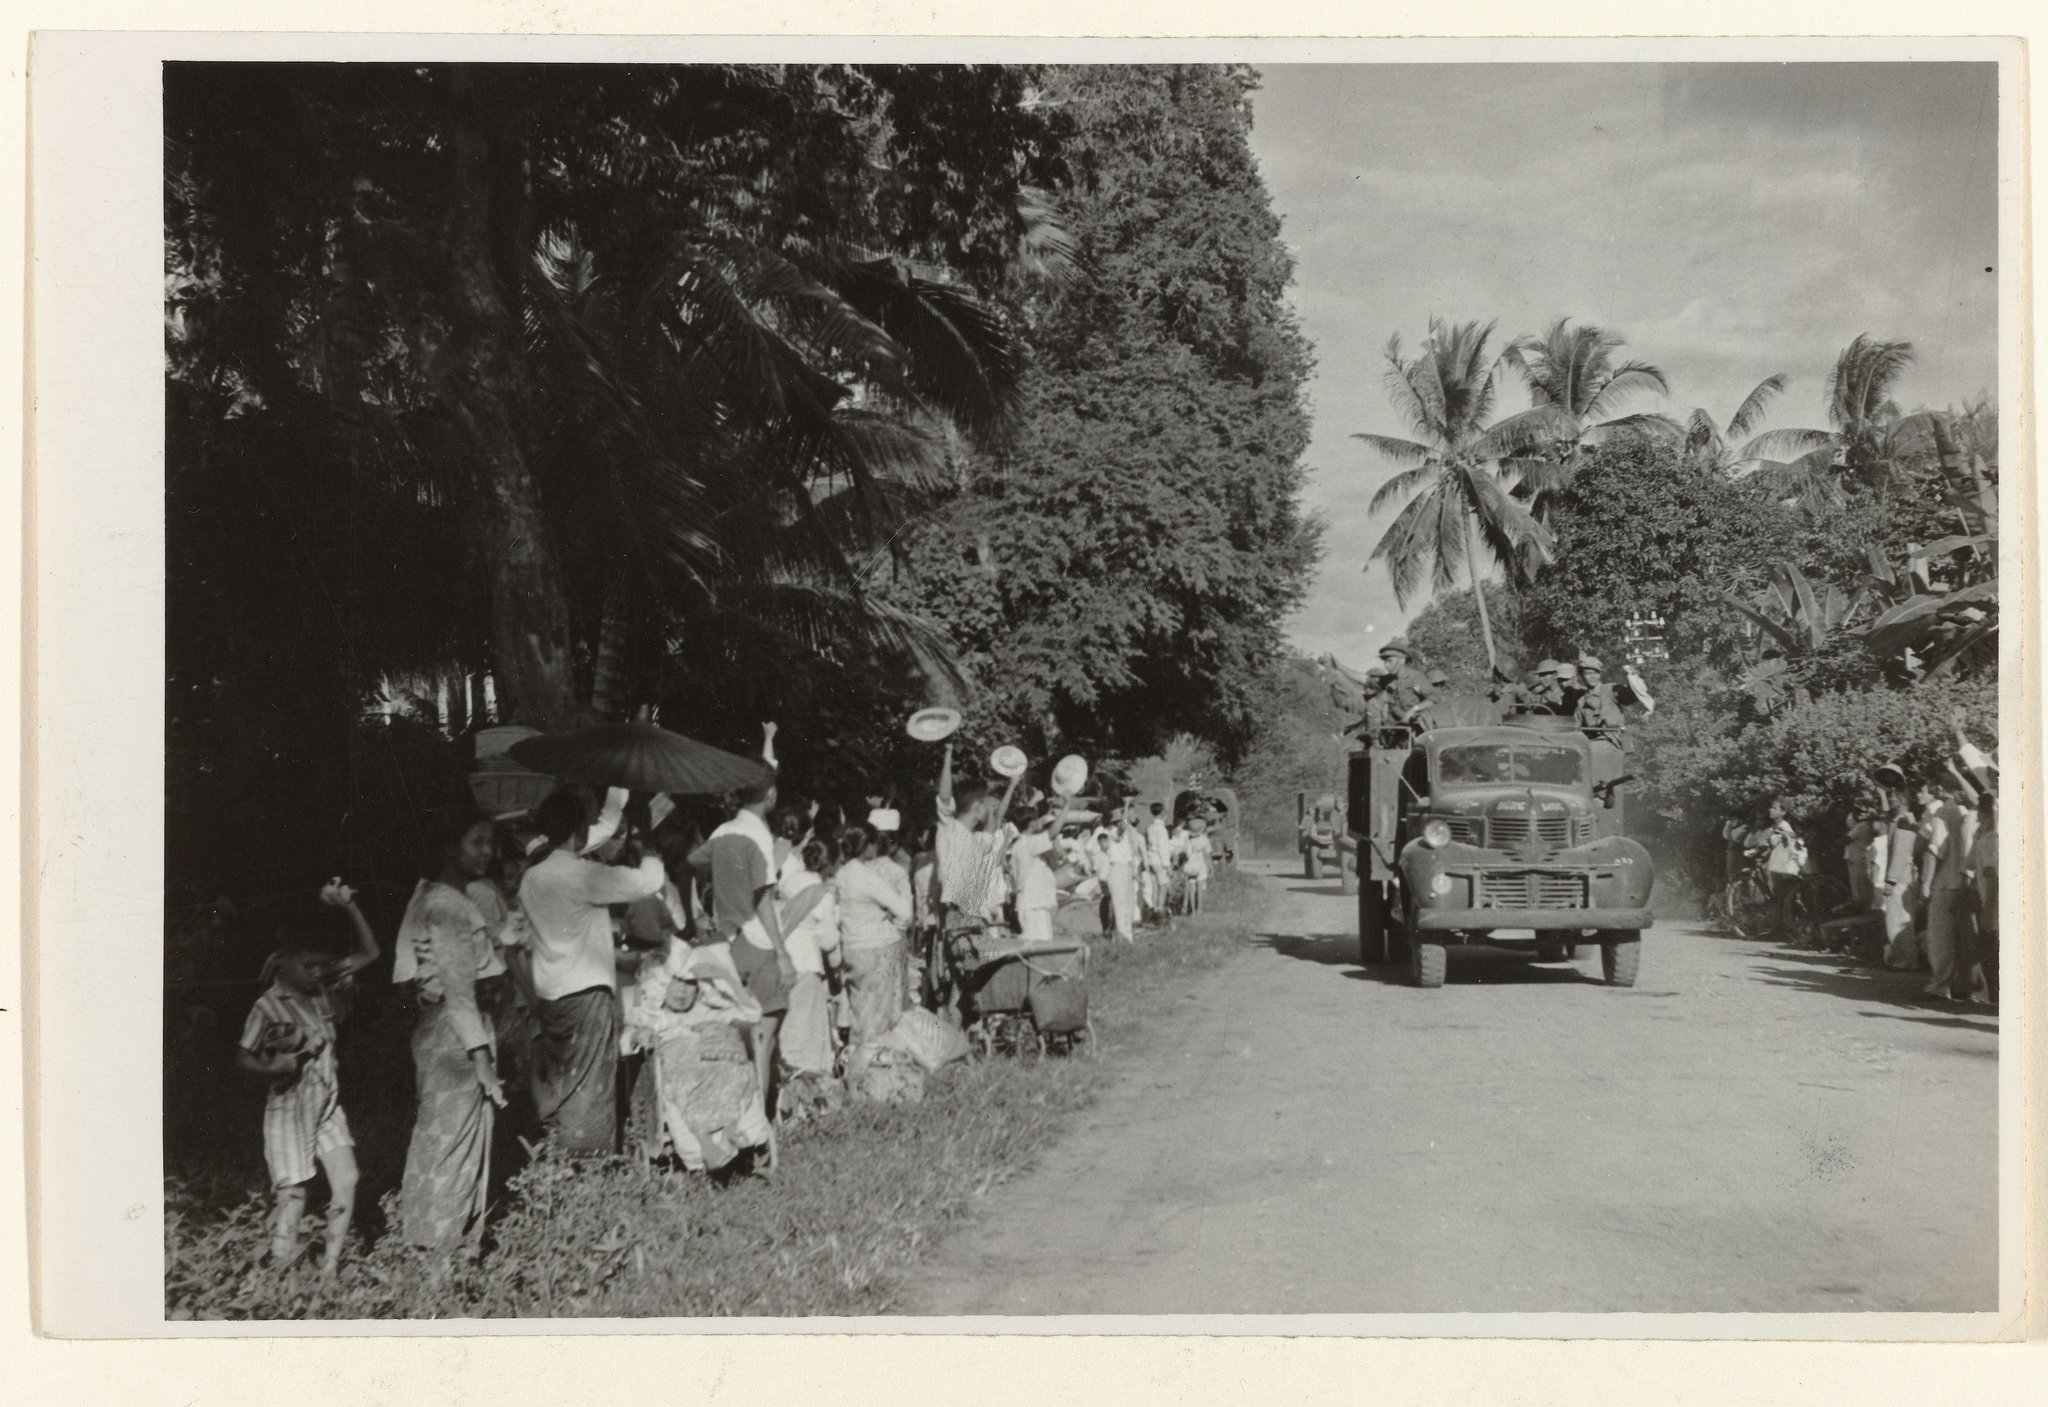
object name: photograph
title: Intocht militairen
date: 1947-1949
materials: photographic support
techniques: photography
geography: java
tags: troop movements, transportation, java, dutch east indies, the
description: Nederlandse militairen rijden in een legerauto een stad binnen. Langs de weg begroet de bevolking hen.